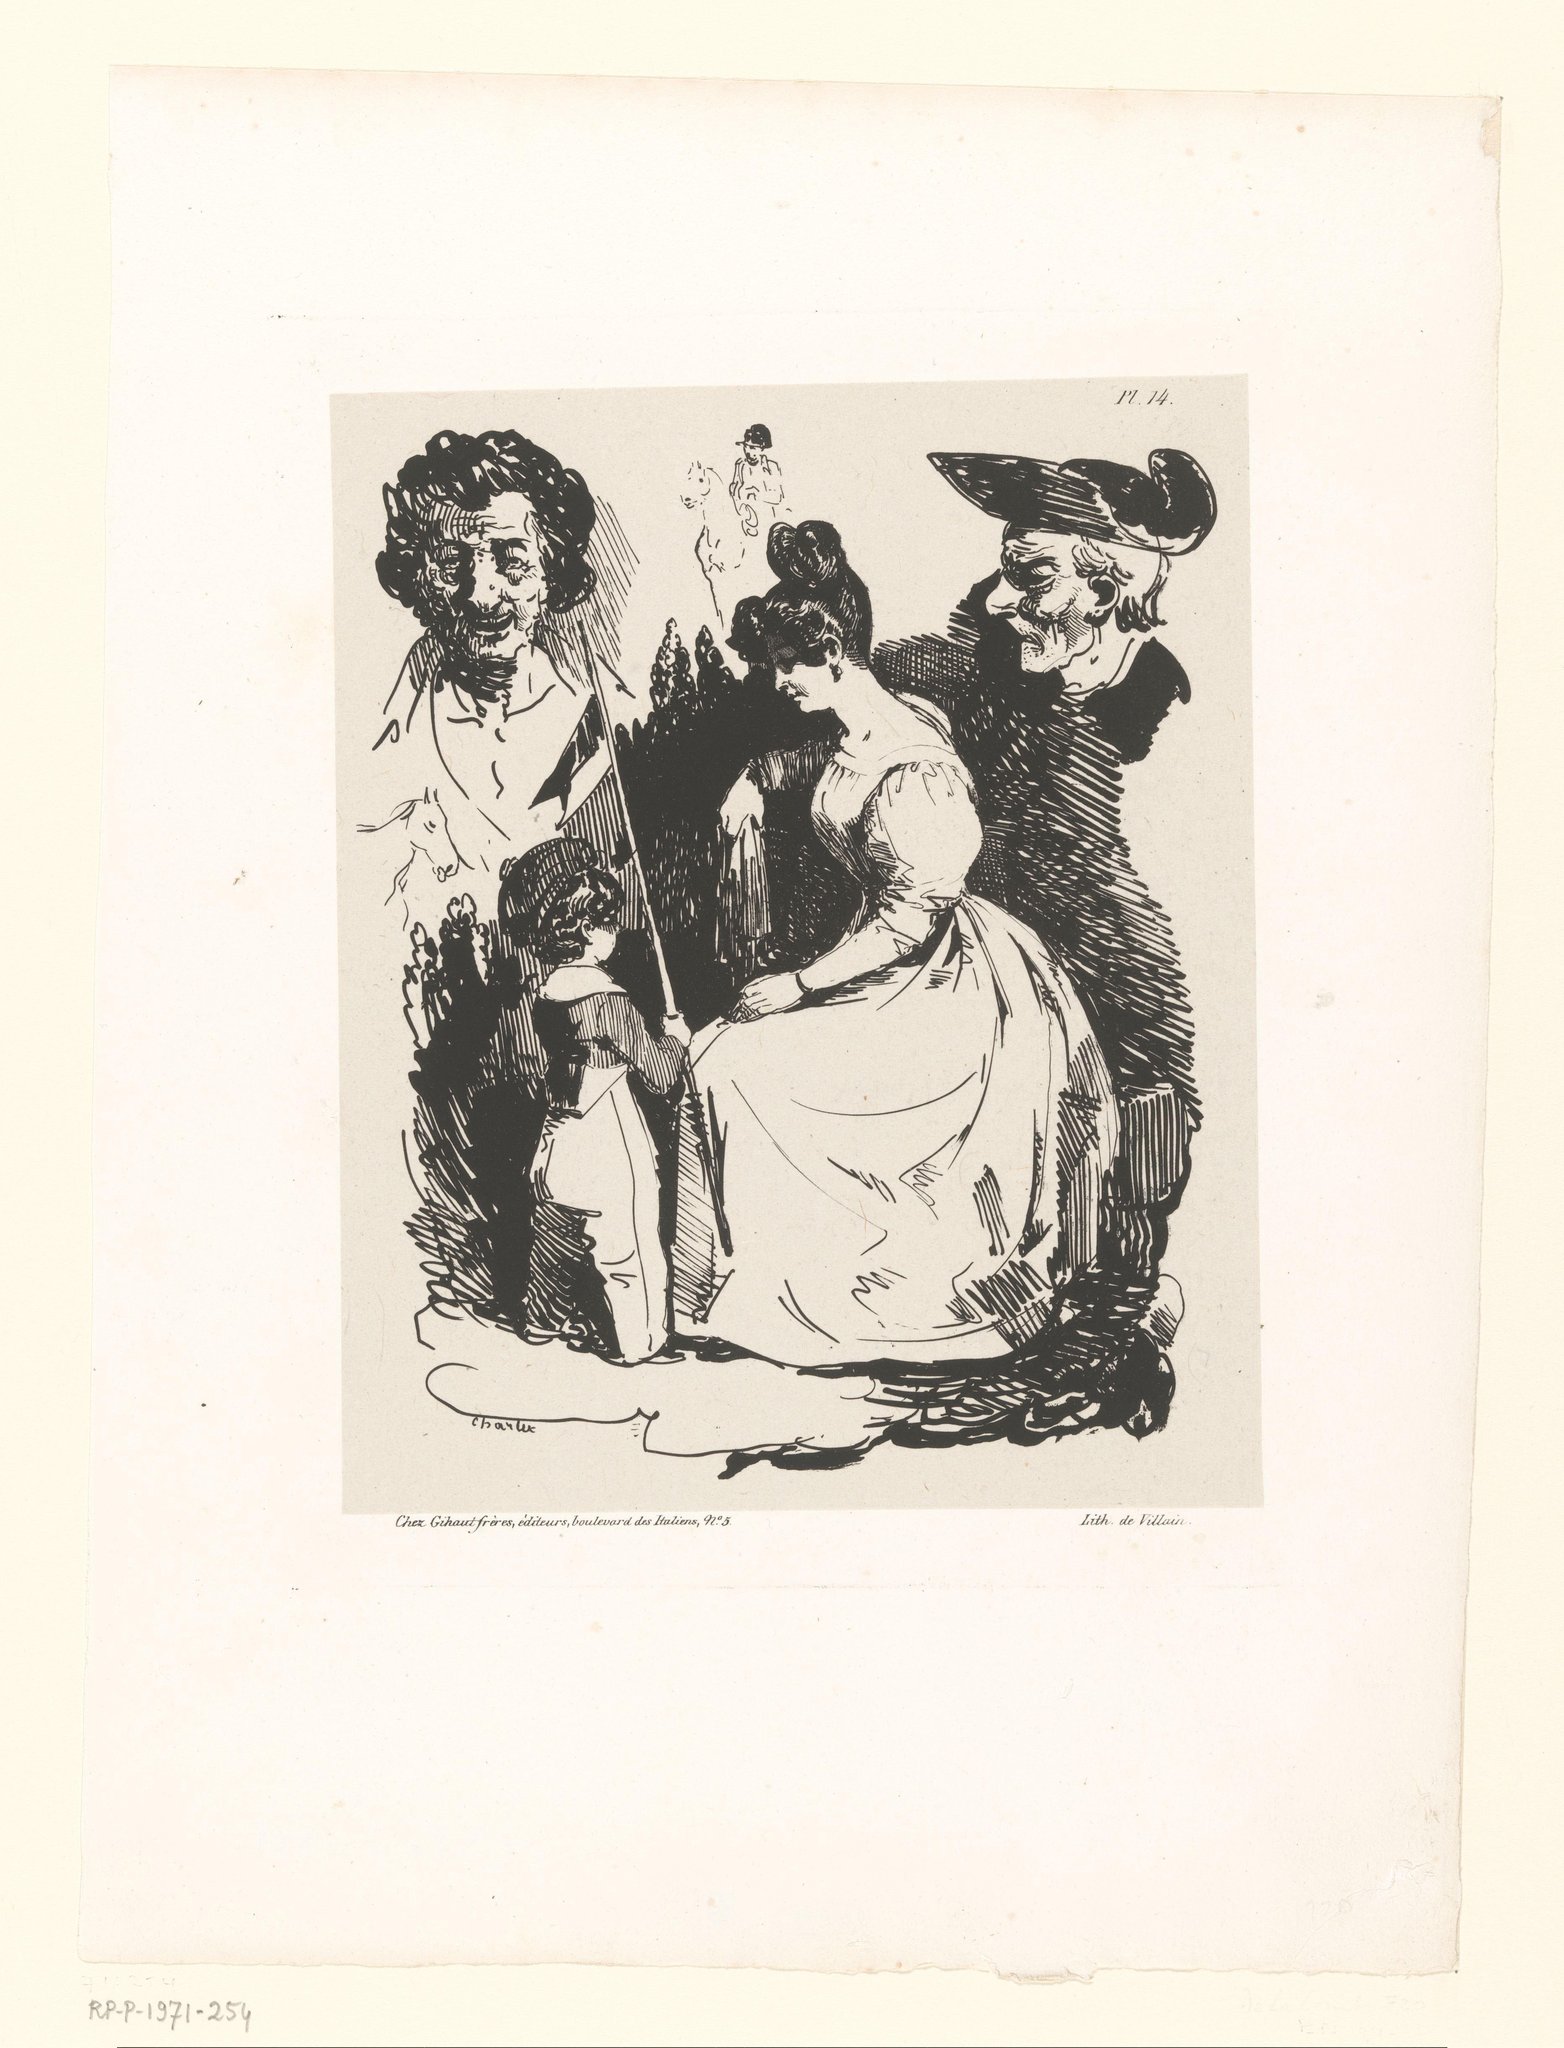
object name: print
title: Croquis et griffonnements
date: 1828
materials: paper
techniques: lithograph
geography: paris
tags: head (human), mother and baby or young child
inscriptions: collector's mark: Lugt 2760, collector's mark: Lugt 2228a